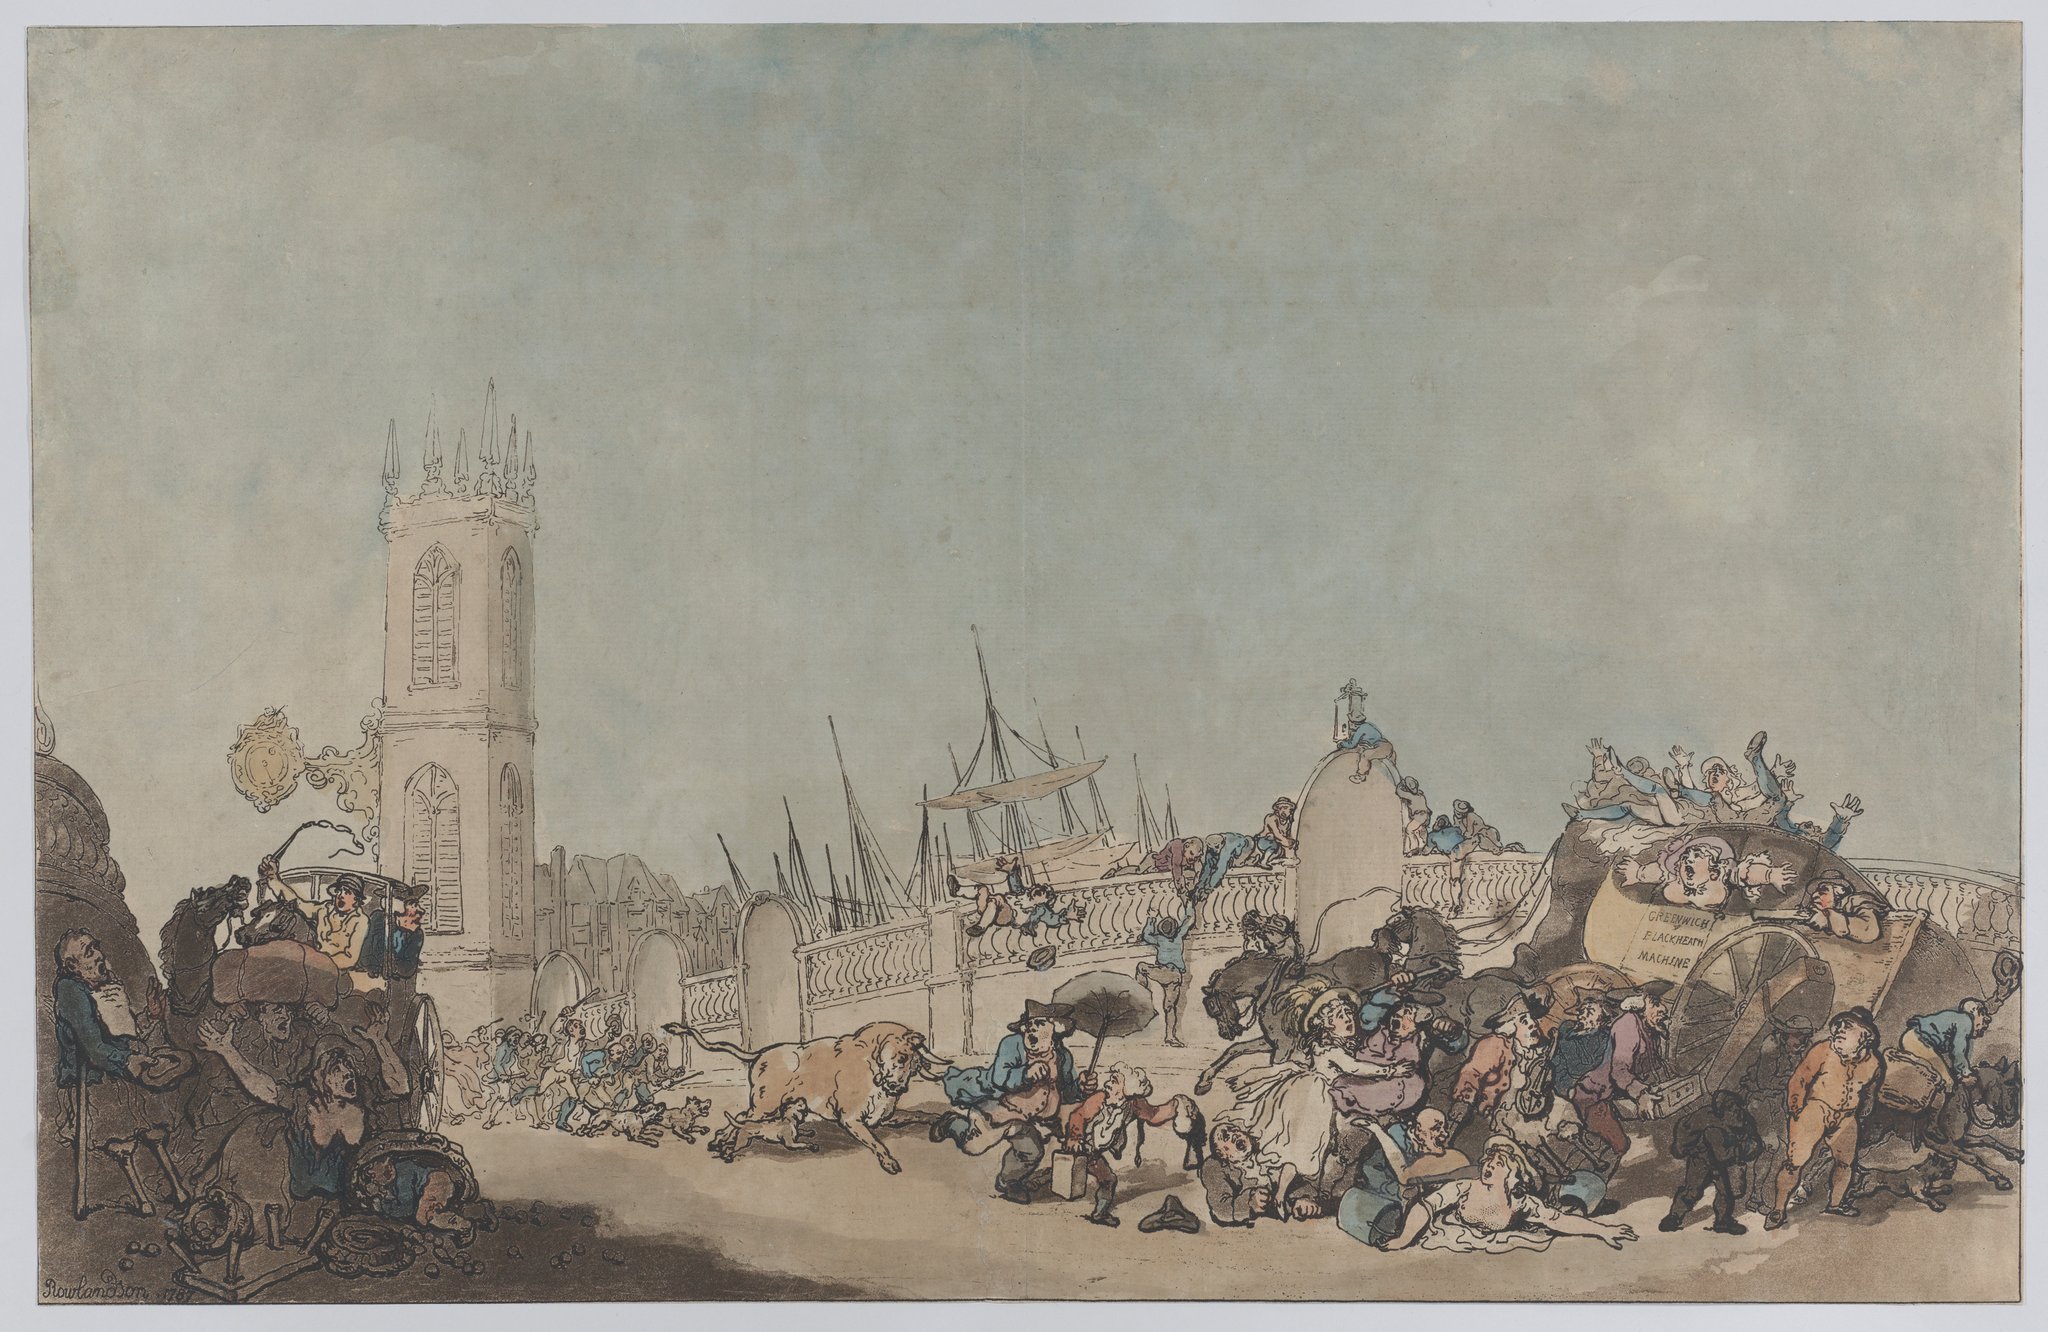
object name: print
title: The Overdrove Ox (Mad Bull on Westminster Bridge)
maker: thomas rowlandson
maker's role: artist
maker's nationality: british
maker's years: 1757-1827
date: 1787-1790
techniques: aquatint, etching